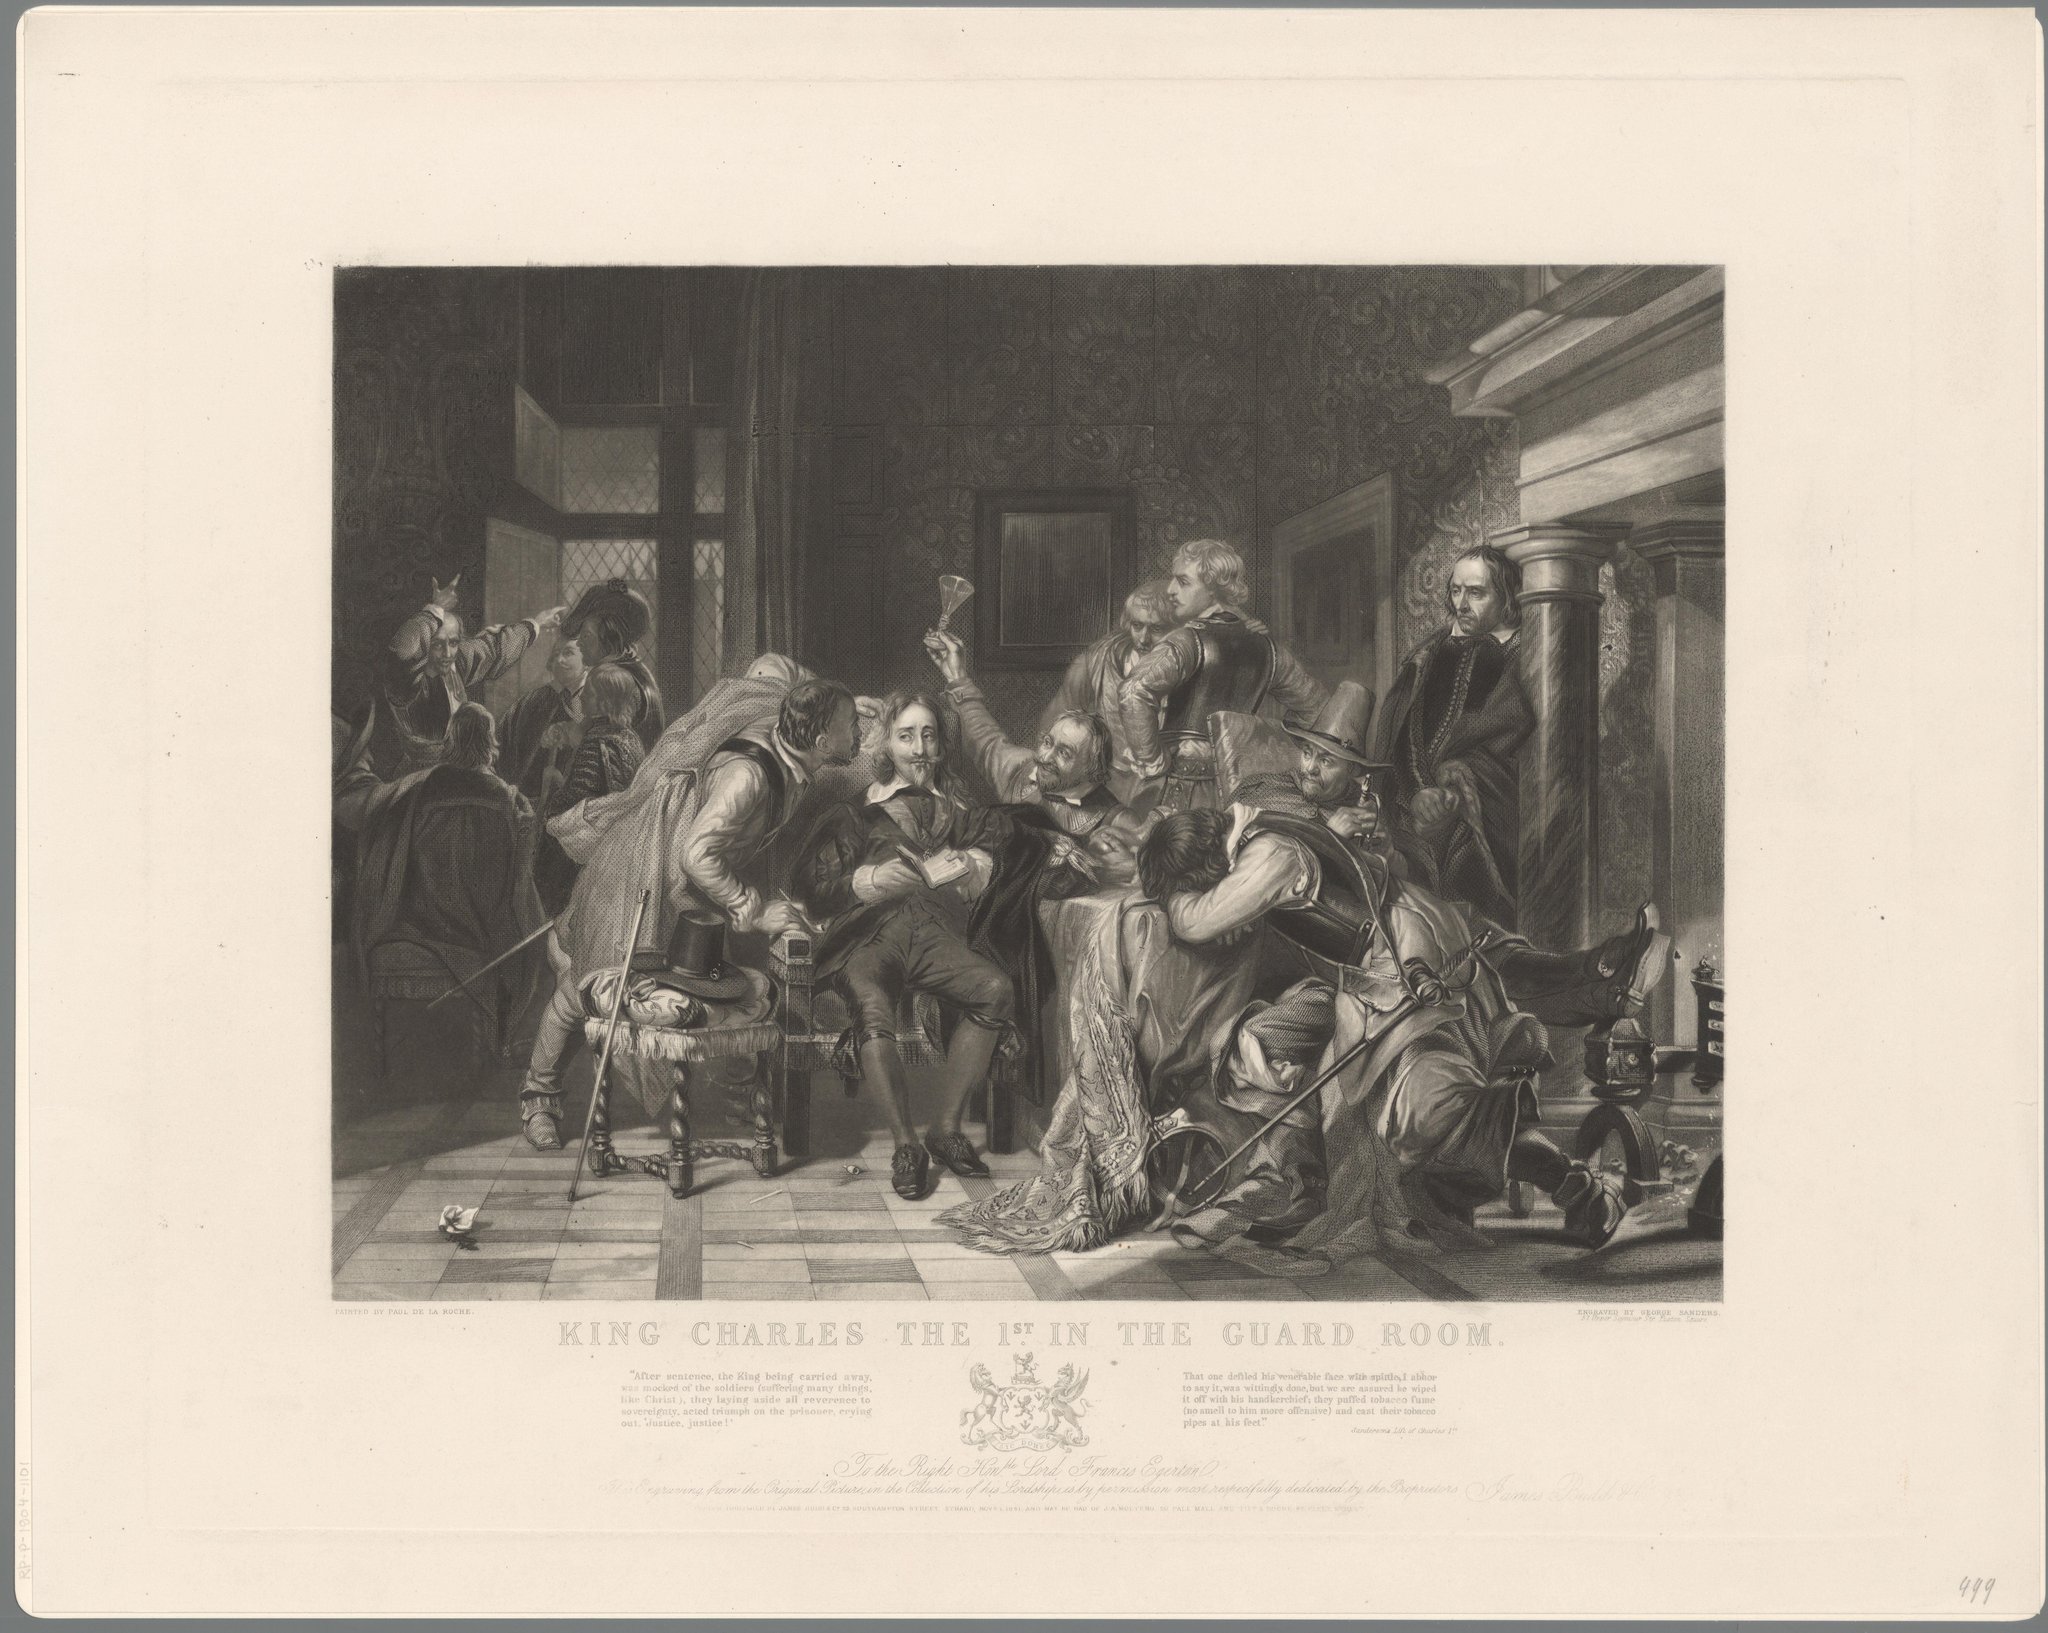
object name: print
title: King Charles the 1st in the Guard Room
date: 1841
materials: paper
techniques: aquatint, engraving, etching, roulette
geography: london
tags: london, karel i (koning van engeland), historical persons, mocking, insulting; teasing, king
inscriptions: collector's mark: Lugt 2228